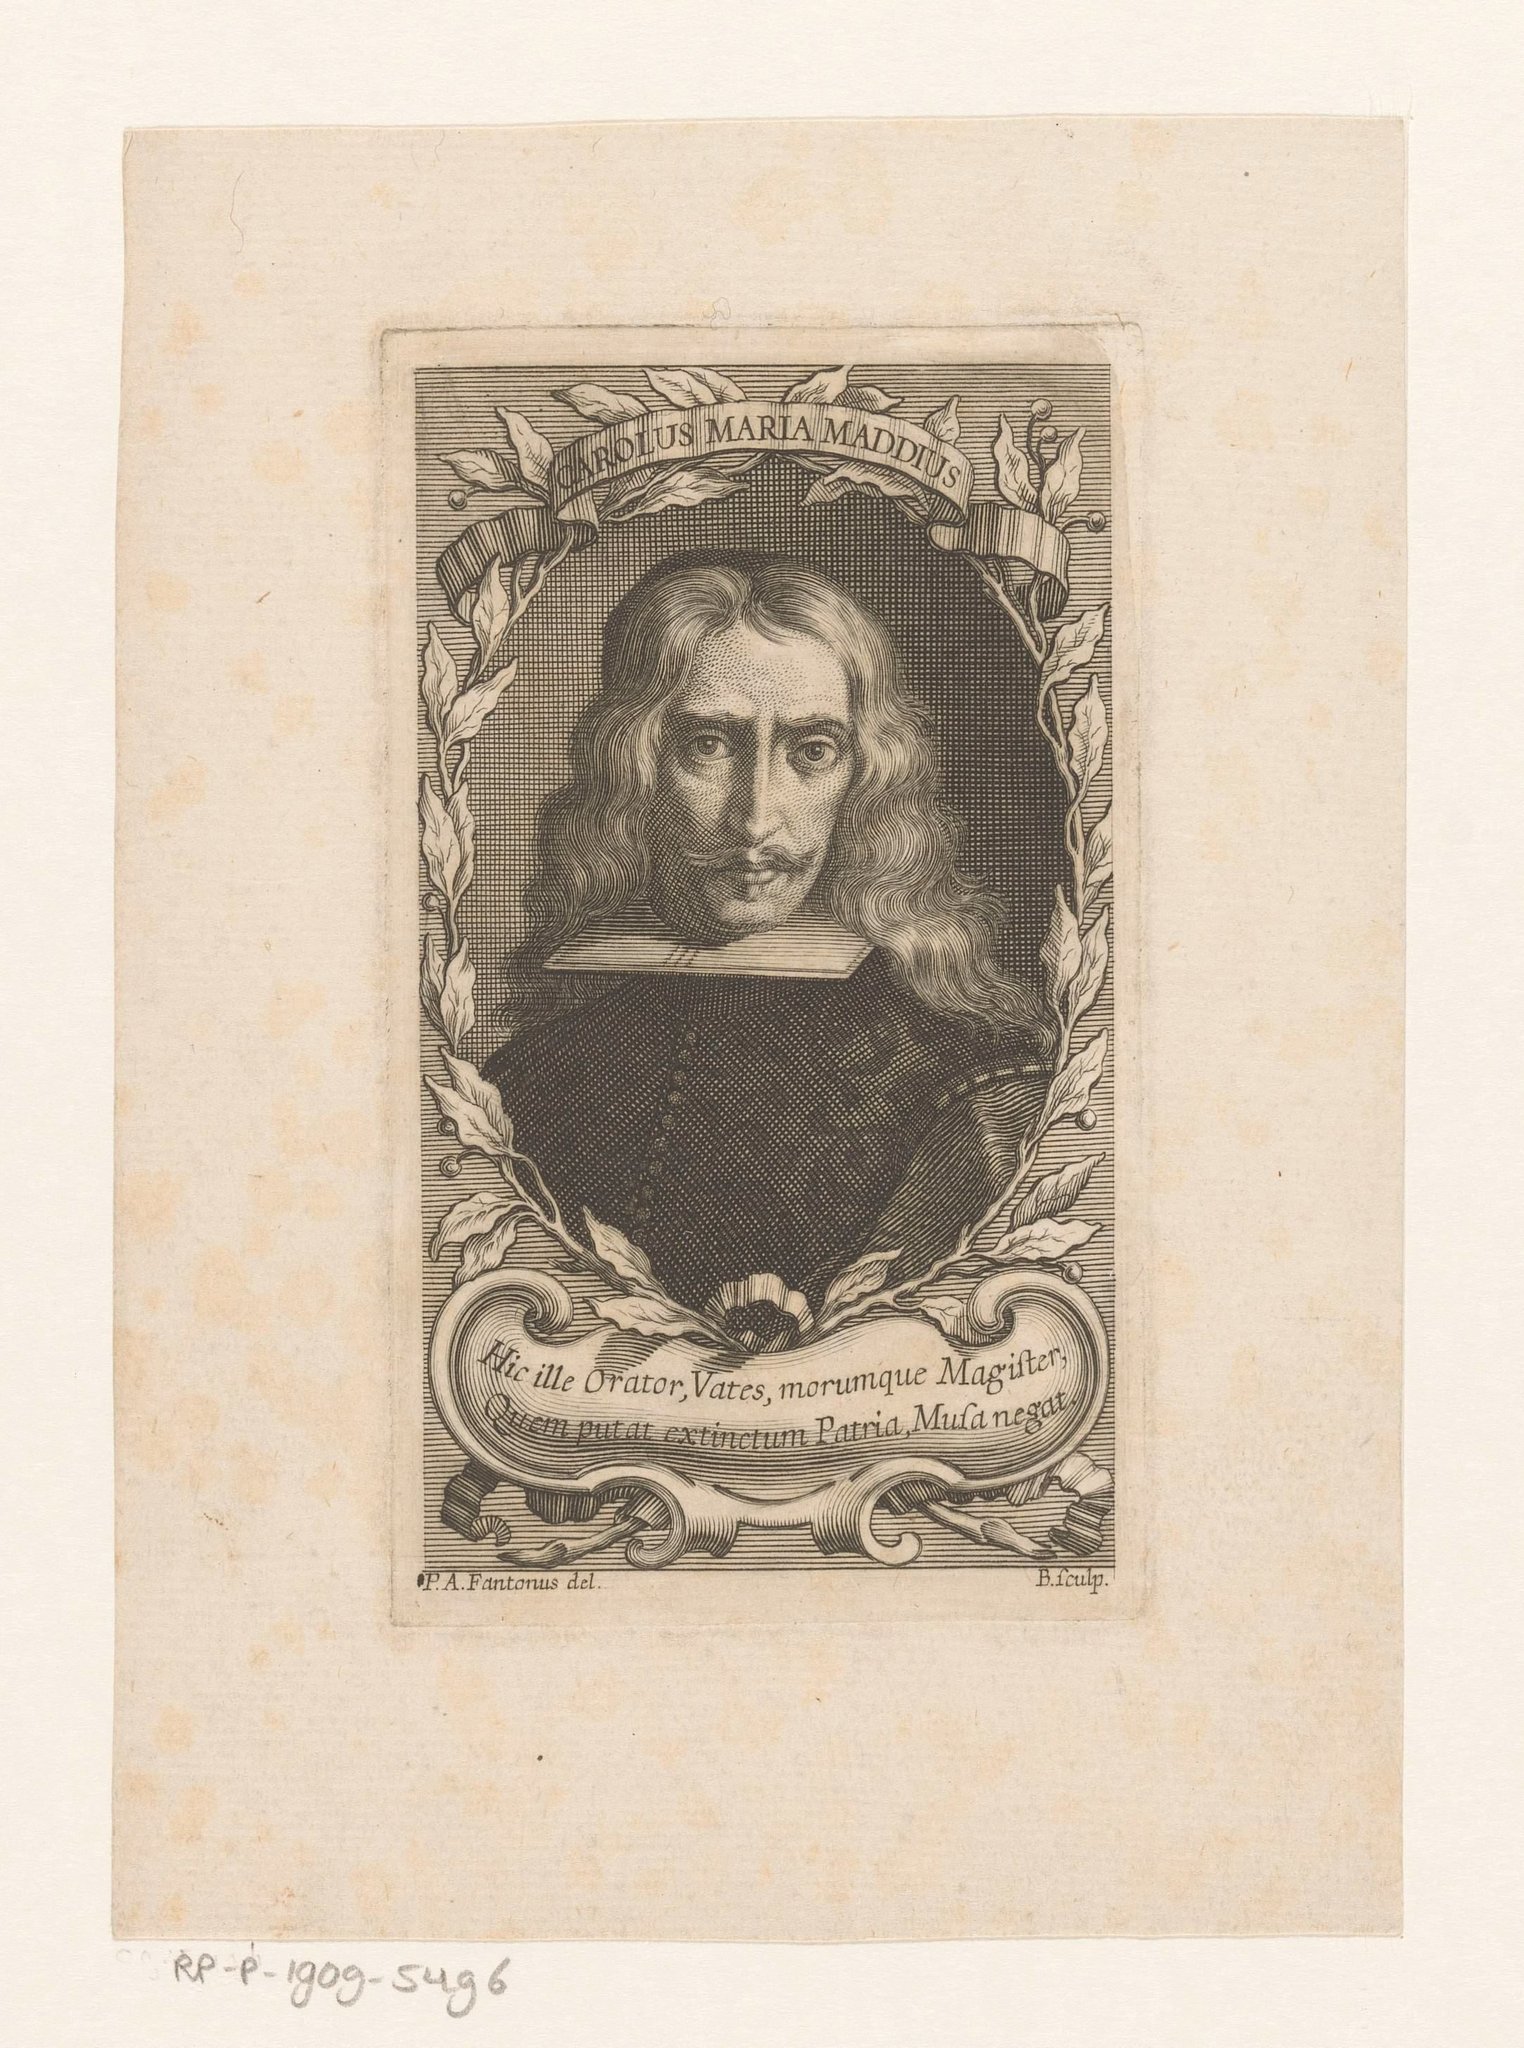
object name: book illustration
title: Portret van schrijver Carlo Maria Maggi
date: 1700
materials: paper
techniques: engraving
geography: italy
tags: historical persons, writer, poet, author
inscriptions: collector's mark: Lugt 2228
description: Prent gebruikt voor: Muratori, Lodovico Antonio. Vita di Carlo Maria Maggi, Milano: Giuseppe Pandolfo Malatesta, 1700.